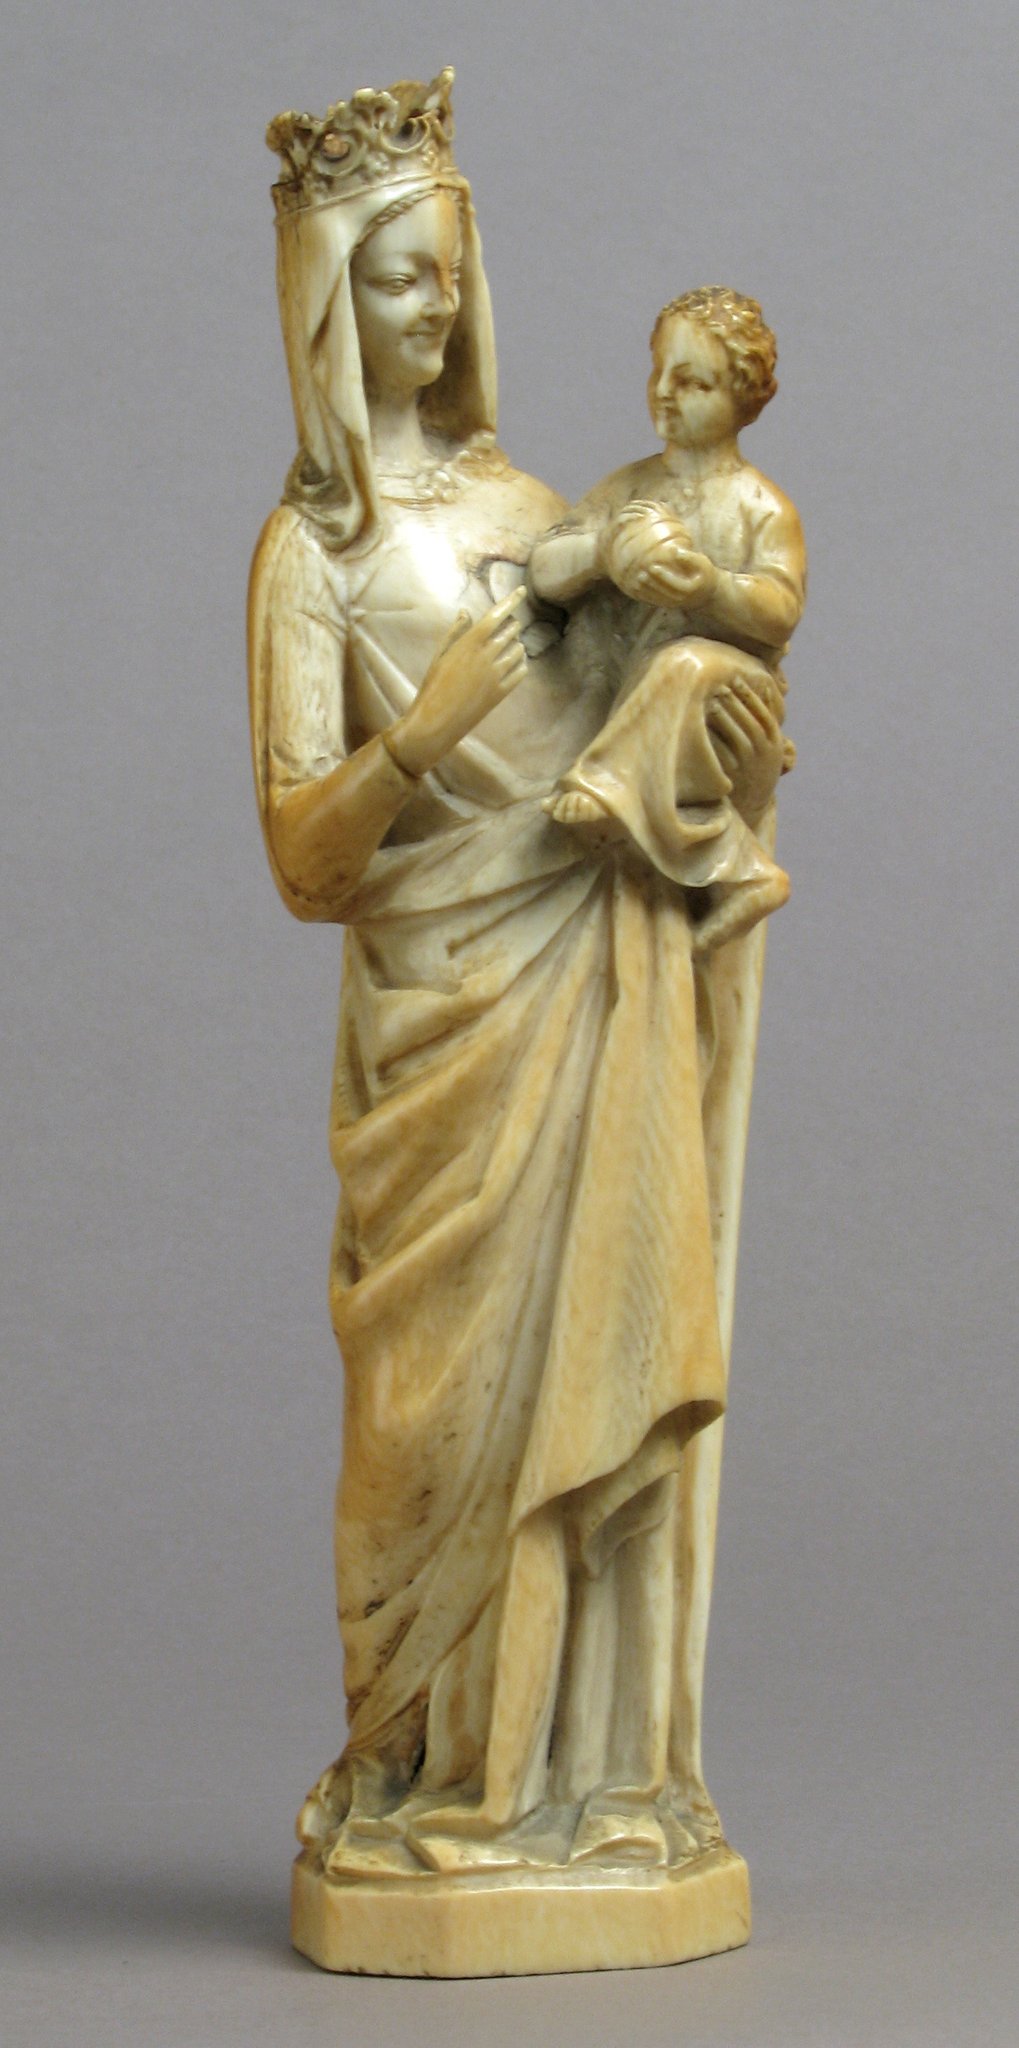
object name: sculpture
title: Virgin and Child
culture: european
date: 1801-1900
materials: ivory